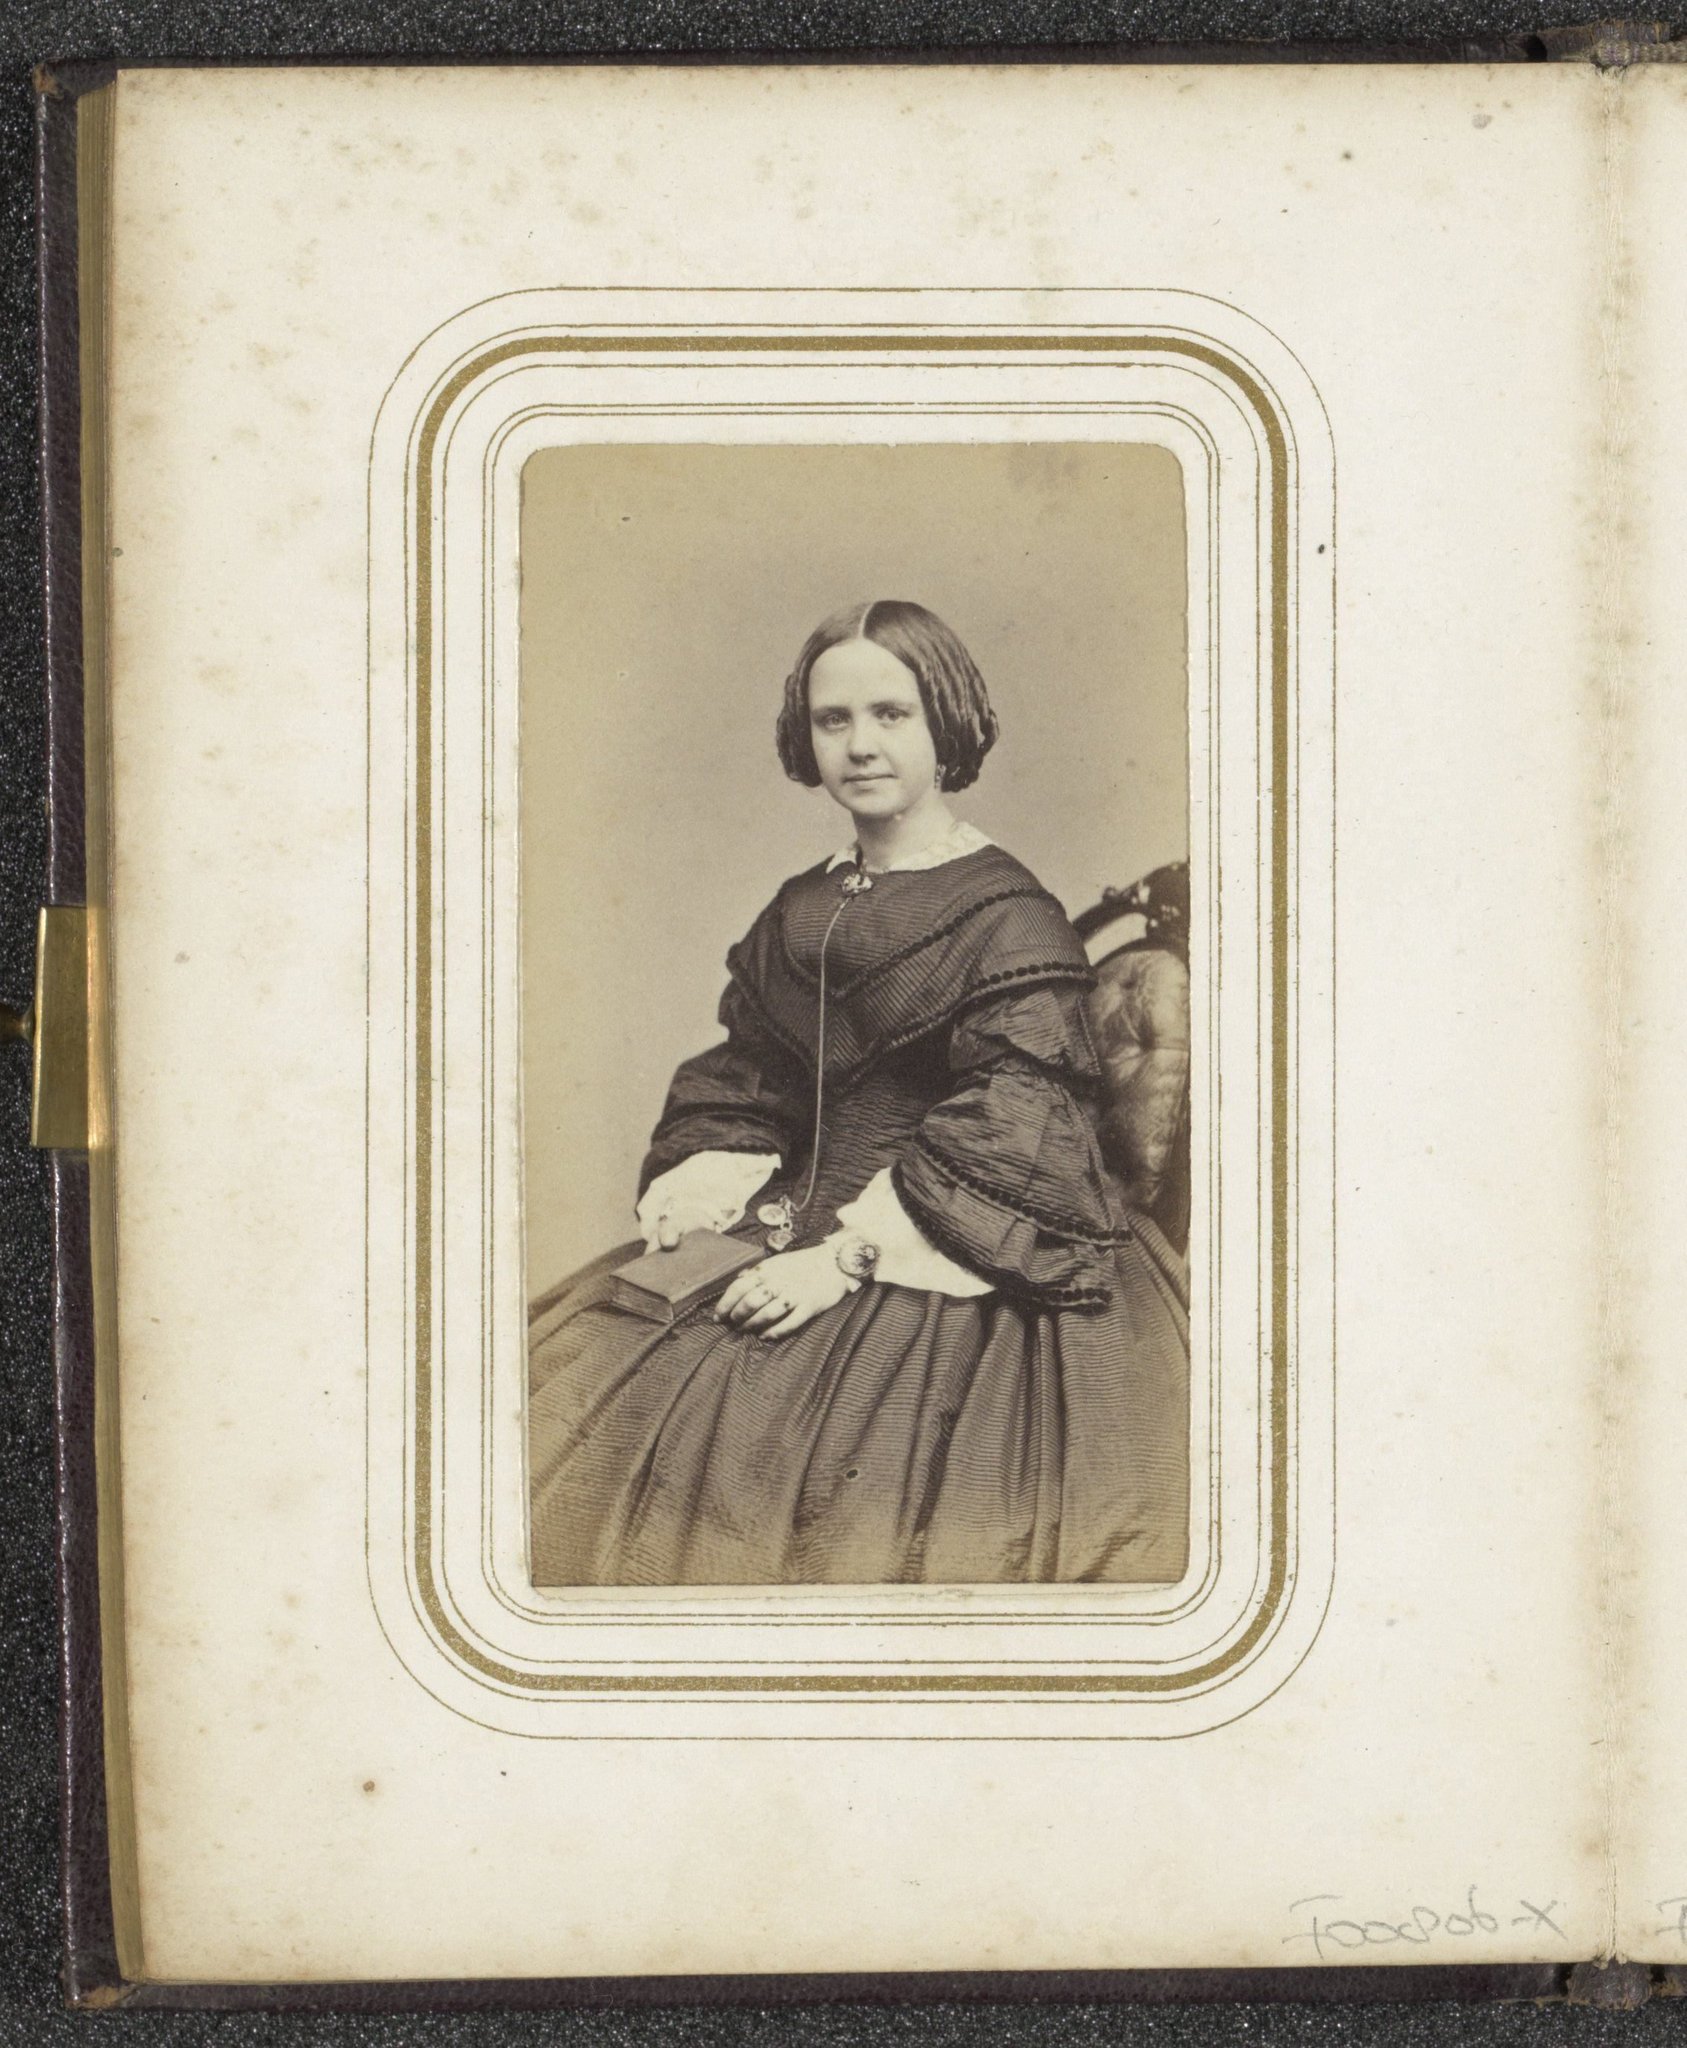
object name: photograph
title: Portret van een zittende jonge vrouw met een boek op schoot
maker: peter carstensen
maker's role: fotograaf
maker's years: 1817-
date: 1854-1868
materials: cardboard, paper, photographic support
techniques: albumen print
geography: amsterdam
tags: eyeglasses, spectacles, studio requisites ~ photographer, historical persons, styles of hairdress - aa - ~ women, brooch, agraffe, clasp, book, dress, gown, amsterdam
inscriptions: address: ‘Amsterdam Nieuwendyk H. 201.’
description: Onderdeel van Fotoalbum met 36 cartes-de-visite van Nederlandse personen.